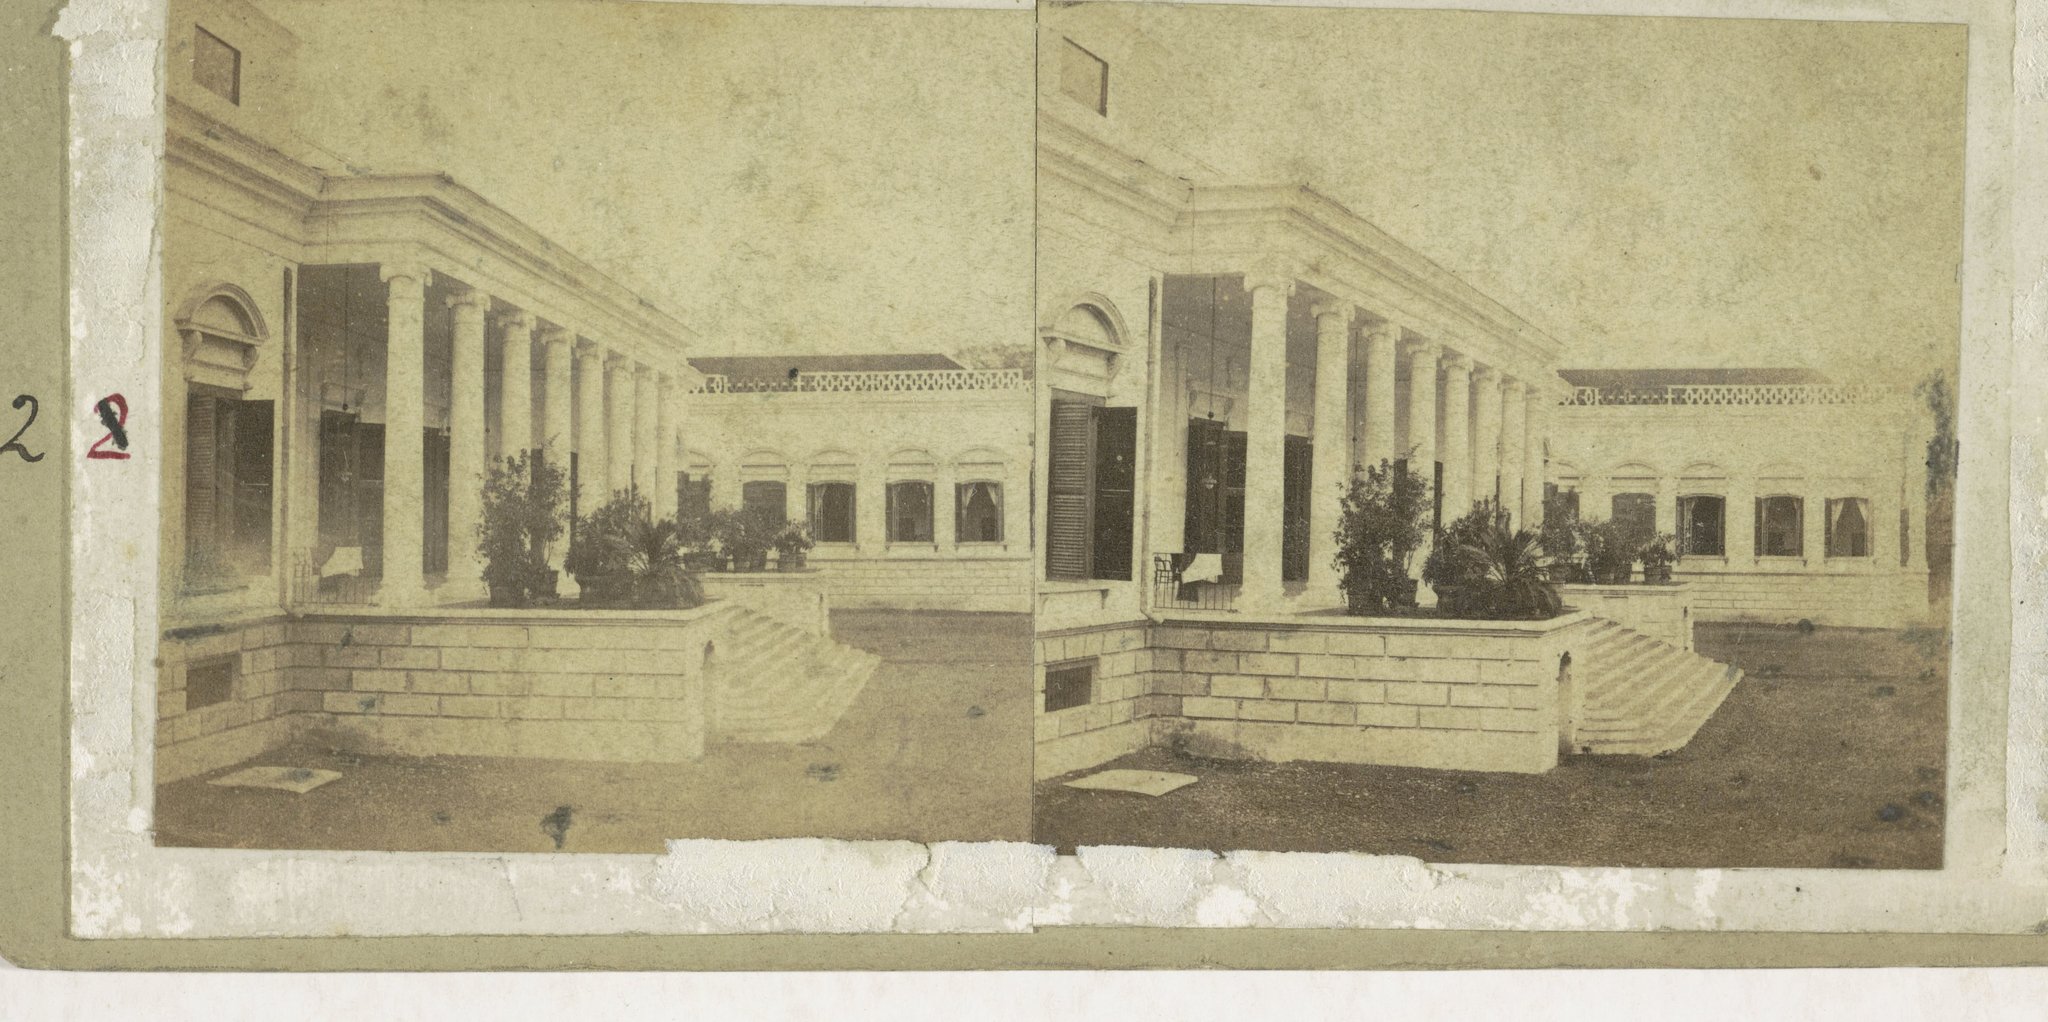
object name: stereograph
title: Gouvernementspaleis te Bogor, Java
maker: Anonymous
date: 1868-1890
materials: cardboard, paper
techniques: albumen print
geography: bogor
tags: palace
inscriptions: inscription: ‘Paleis van den Gouv. Gener. N. zijde te Buitenzorg. 833'/ van uit het logeergebouw gezien.’, number: ‘2’